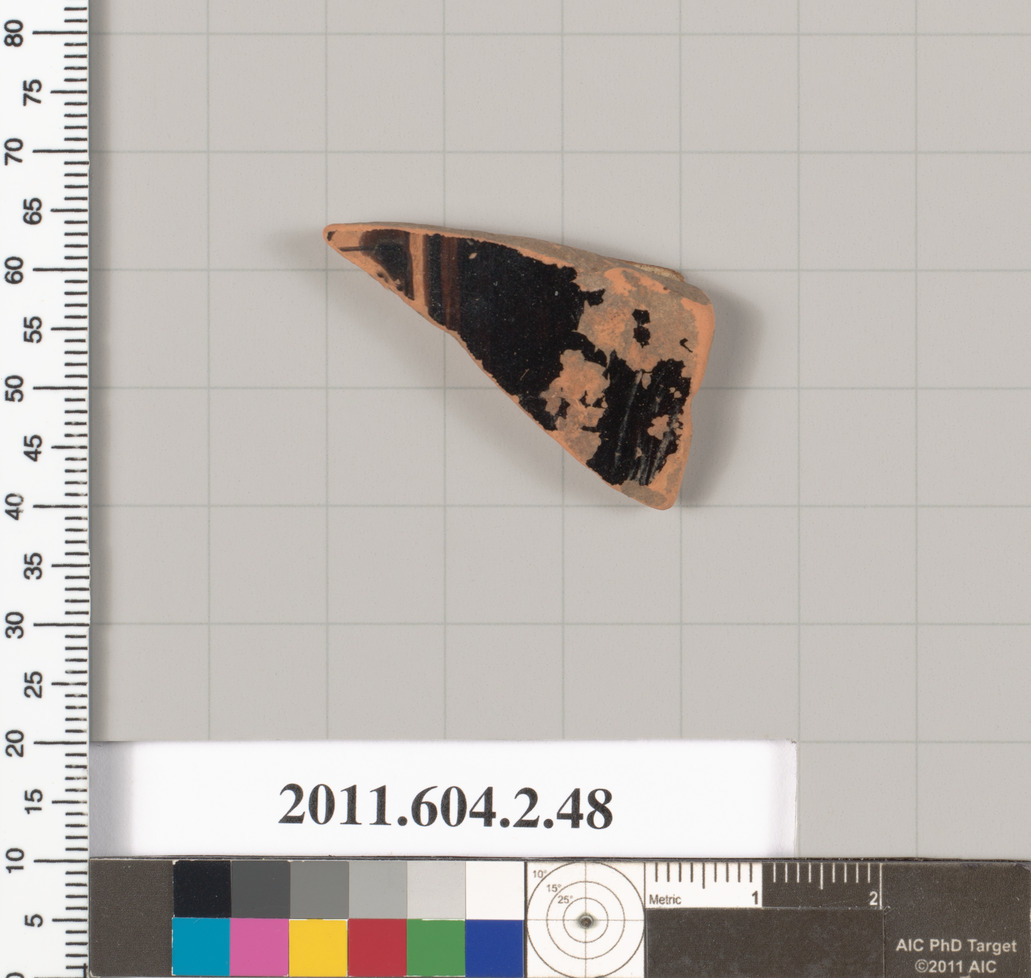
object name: pelike fragment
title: Terracotta fragment of a pelike (jar)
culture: greek, attic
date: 510-490 BCE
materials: terracotta